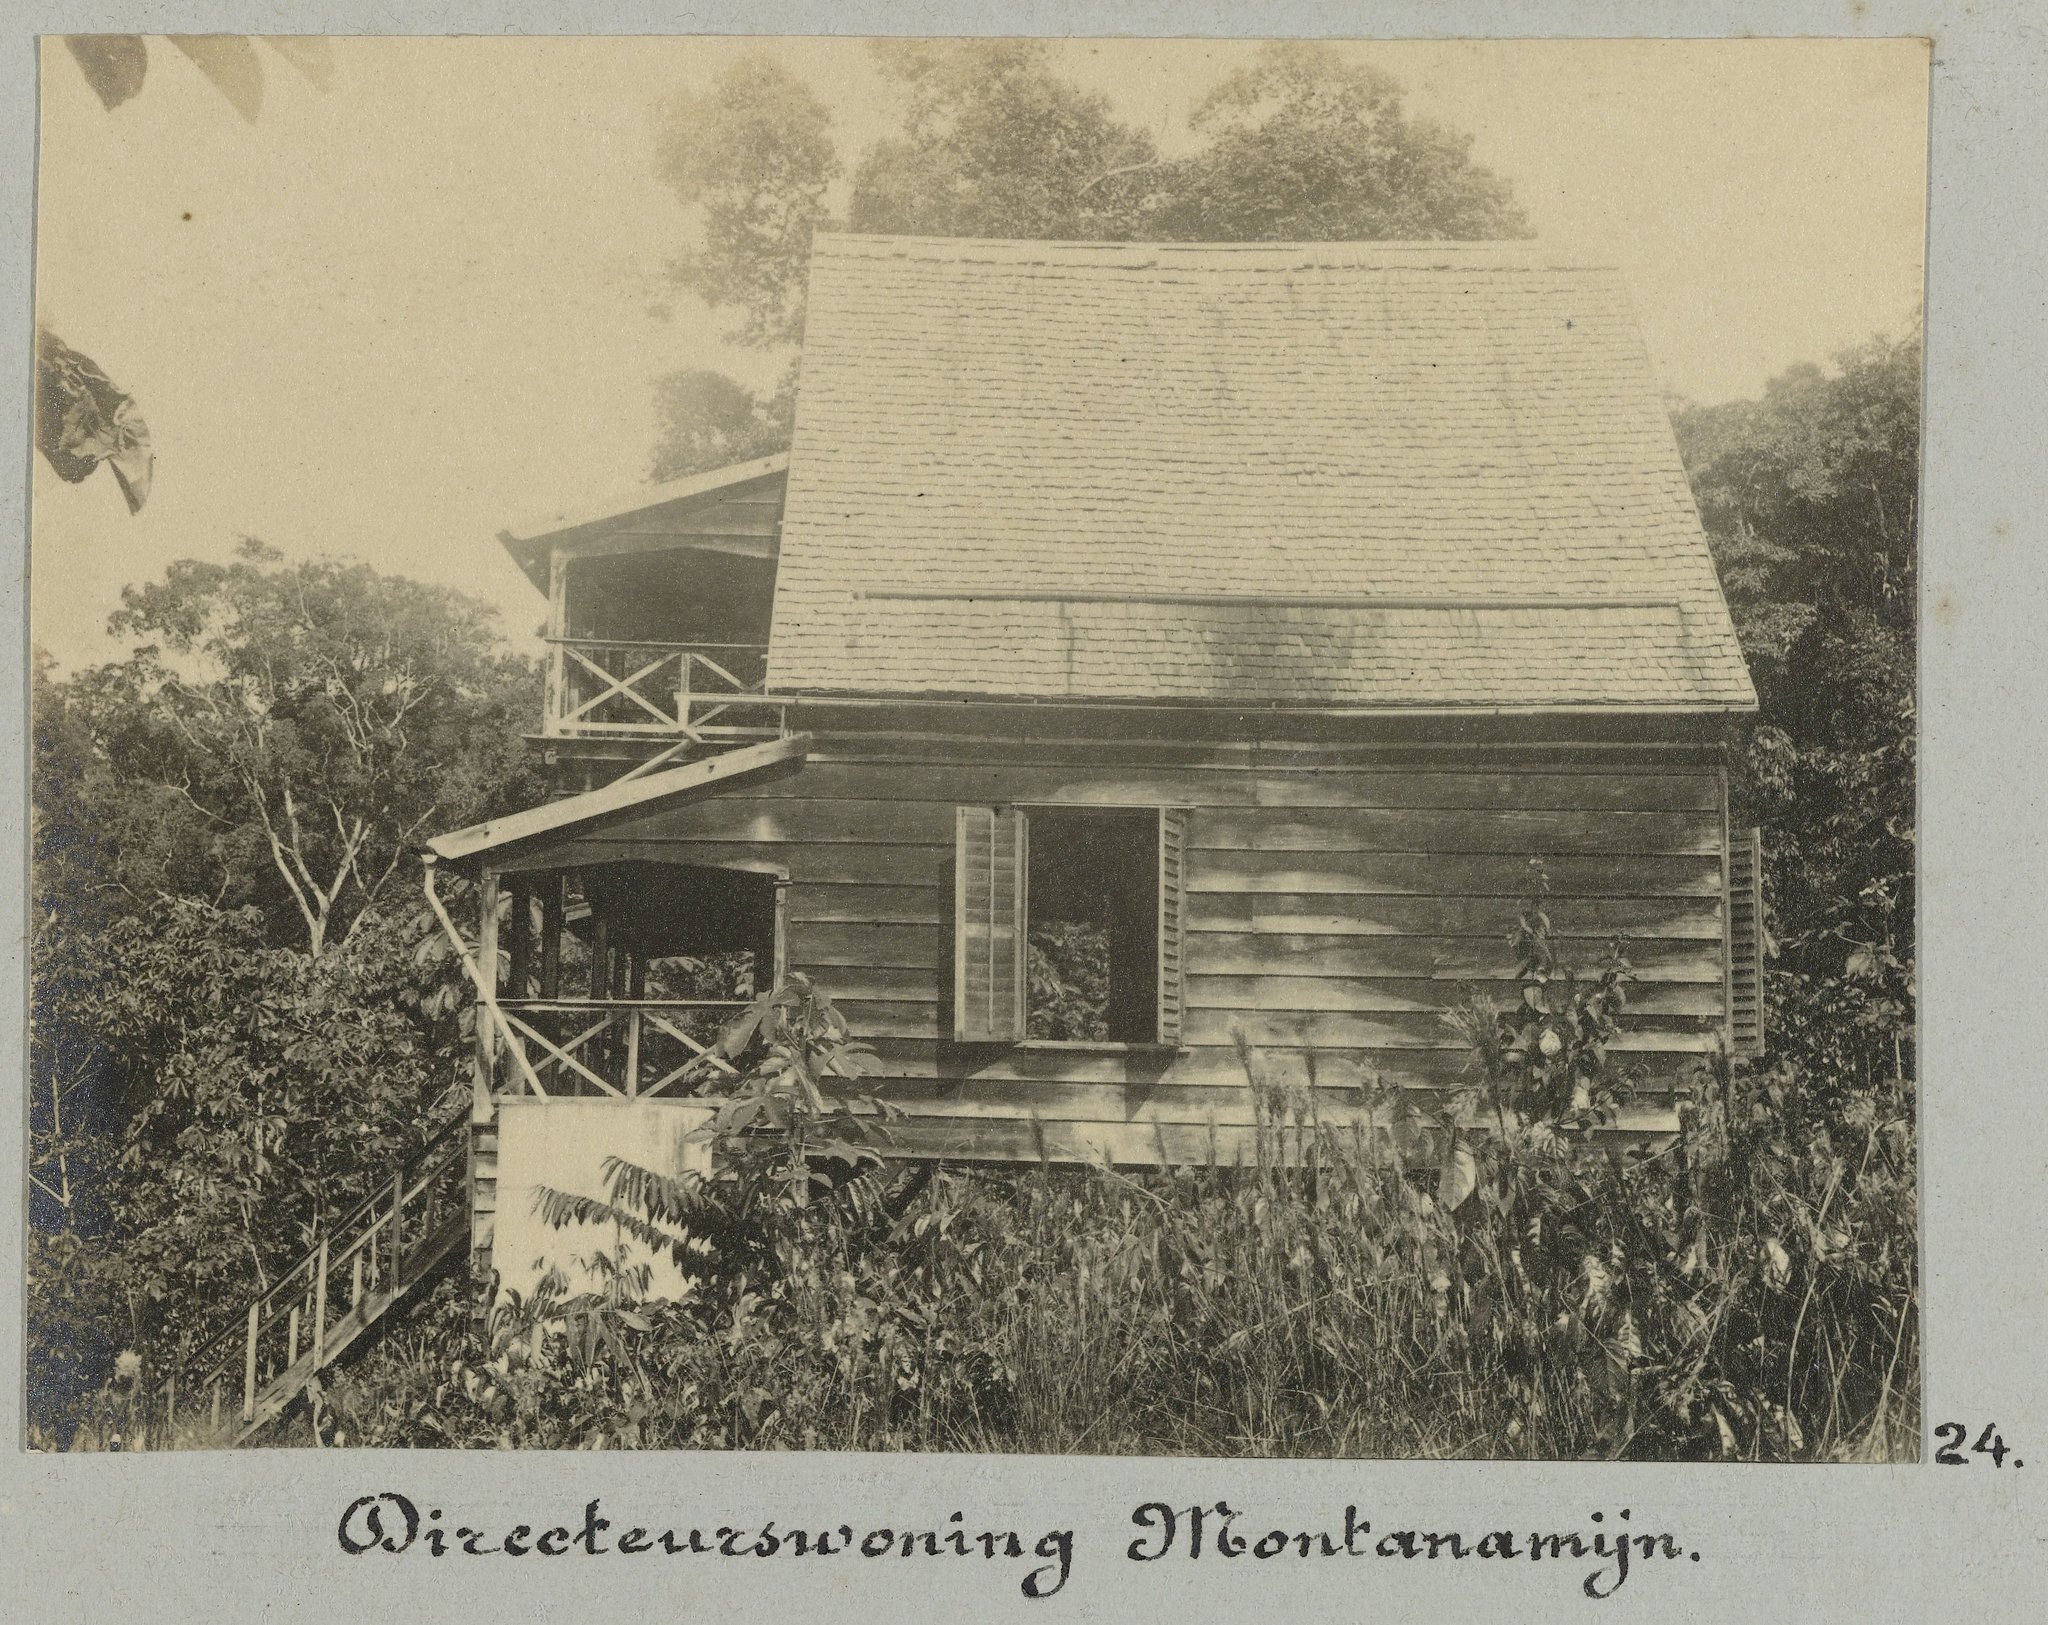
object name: photograph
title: Directeurswoning Montanamijn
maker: hendrik doijer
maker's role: engineer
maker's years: 1863-1925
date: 1903-1910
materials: photographic support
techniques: gelatin silver print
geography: suriname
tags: suriname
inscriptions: inscription: ‘24. / Directeurswoning Montanamijn.’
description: Gezicht op de directeurswoning van de Montana-mijn. Onderdeel van het fotoalbum Souvenir de Voyage (deel 1), over het leven van de familie Doijer in en rond de plantage Ma Retraite in Suriname in de jaren 1903-1910.